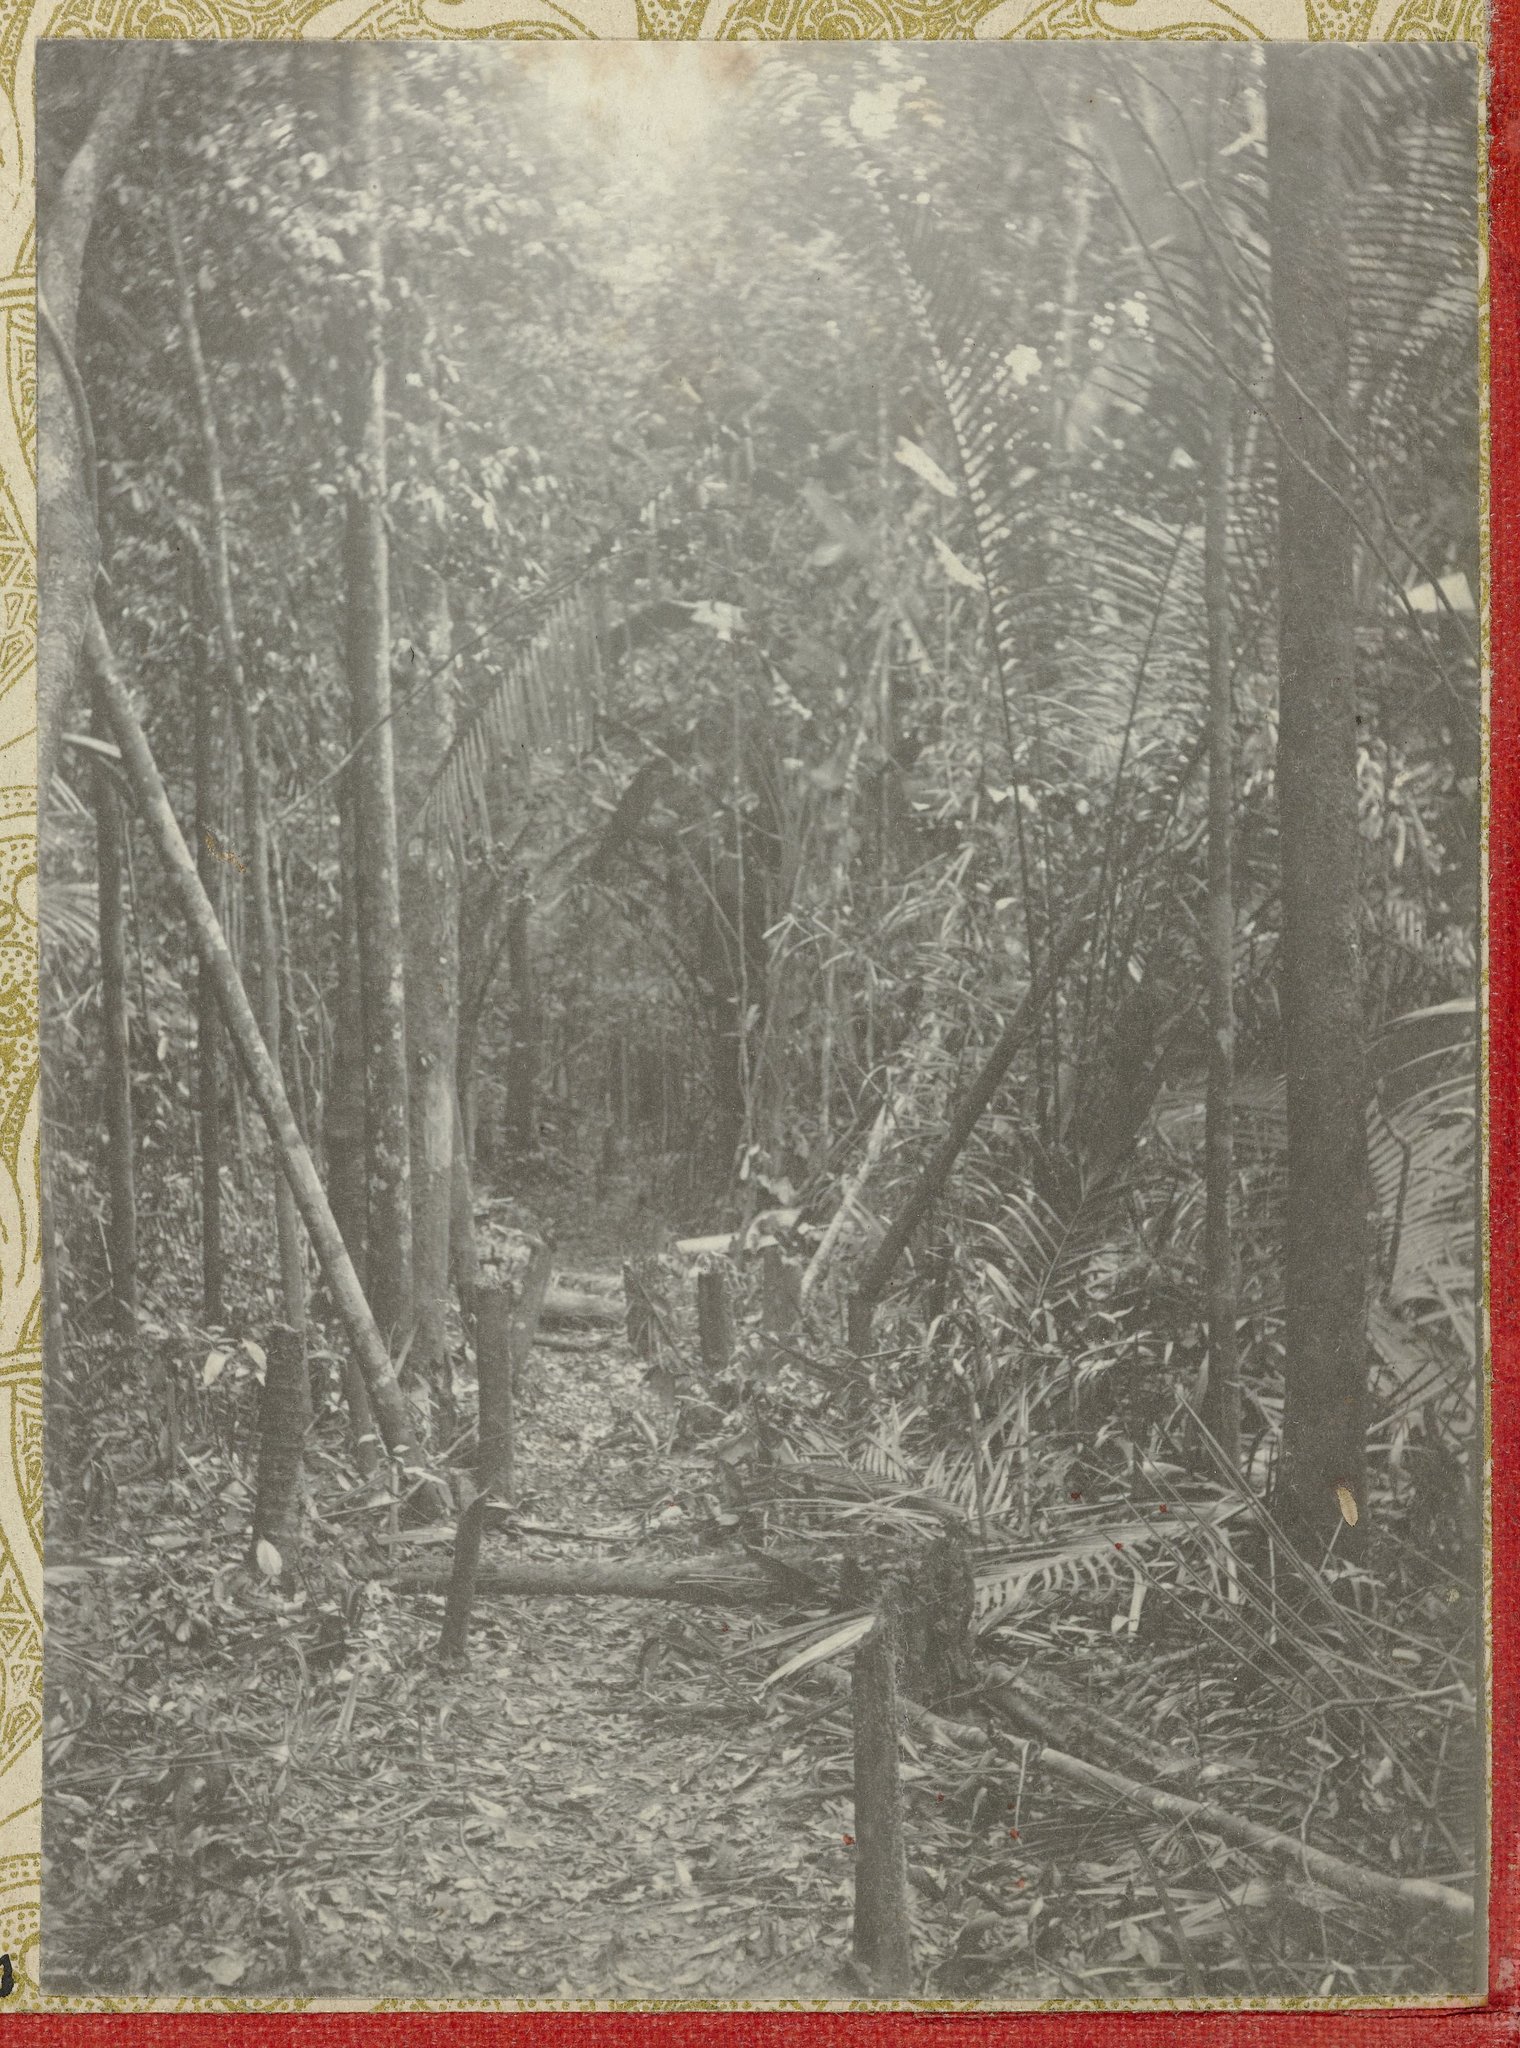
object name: photograph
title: Doorgang door het woud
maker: hendrik doijer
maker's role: engineer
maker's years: 1863-1925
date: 1903-1910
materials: photographic support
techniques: gelatin silver print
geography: suriname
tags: suriname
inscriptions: inscription: ‘21’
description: Pad gemaakt door het oerwoud door bomen te kappen. Onderdeel van het fotoalbum Souvenir de Voyage (deel 2), over het leven van de familie Doijer in en rond de plantage Ma Retraite in Suriname in de jaren 1903-1910.